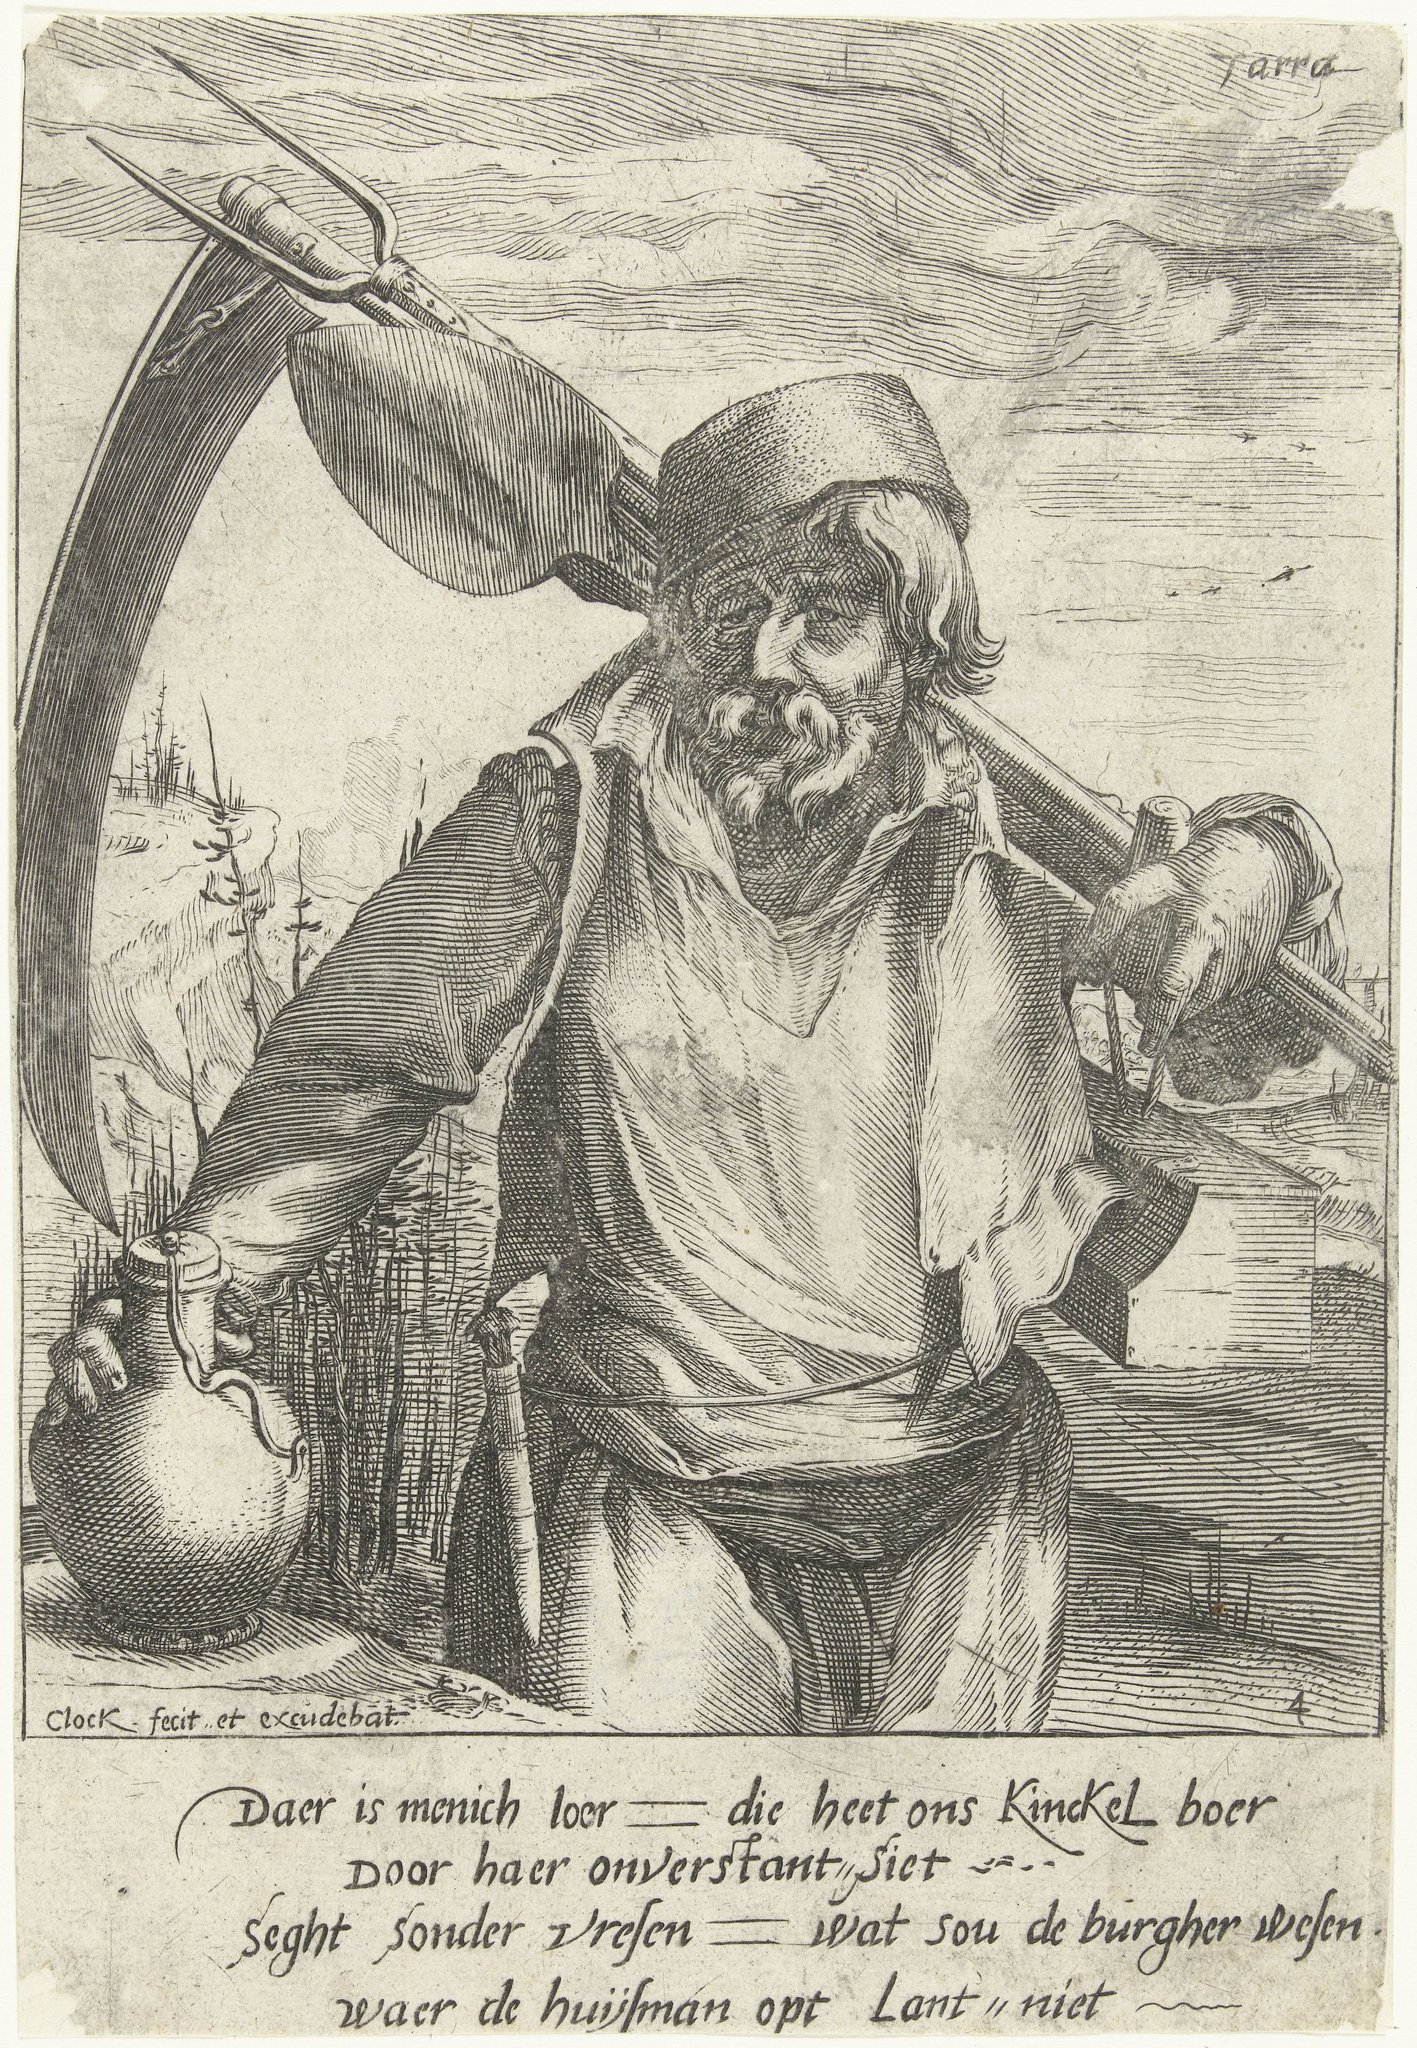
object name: print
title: De vier elementen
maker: nicolaes jansz. clock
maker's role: print maker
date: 1597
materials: paper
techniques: engraving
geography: haarlem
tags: earth (one of the four elements), farmers, agricultural implements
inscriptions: collector's mark: Lugt 2228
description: Een landbouwer met zijn werktuigen (spade, riek en zeis) over zijn schouder. In zijn rechterhand houdt hij een kruik vast. De landbouwer staat symbool voor het element aarde. De prent heeft een Nederlands onderschrift dat de landbouwer prijst. De prent is deel van een vierdelige serie over de vier elementen.